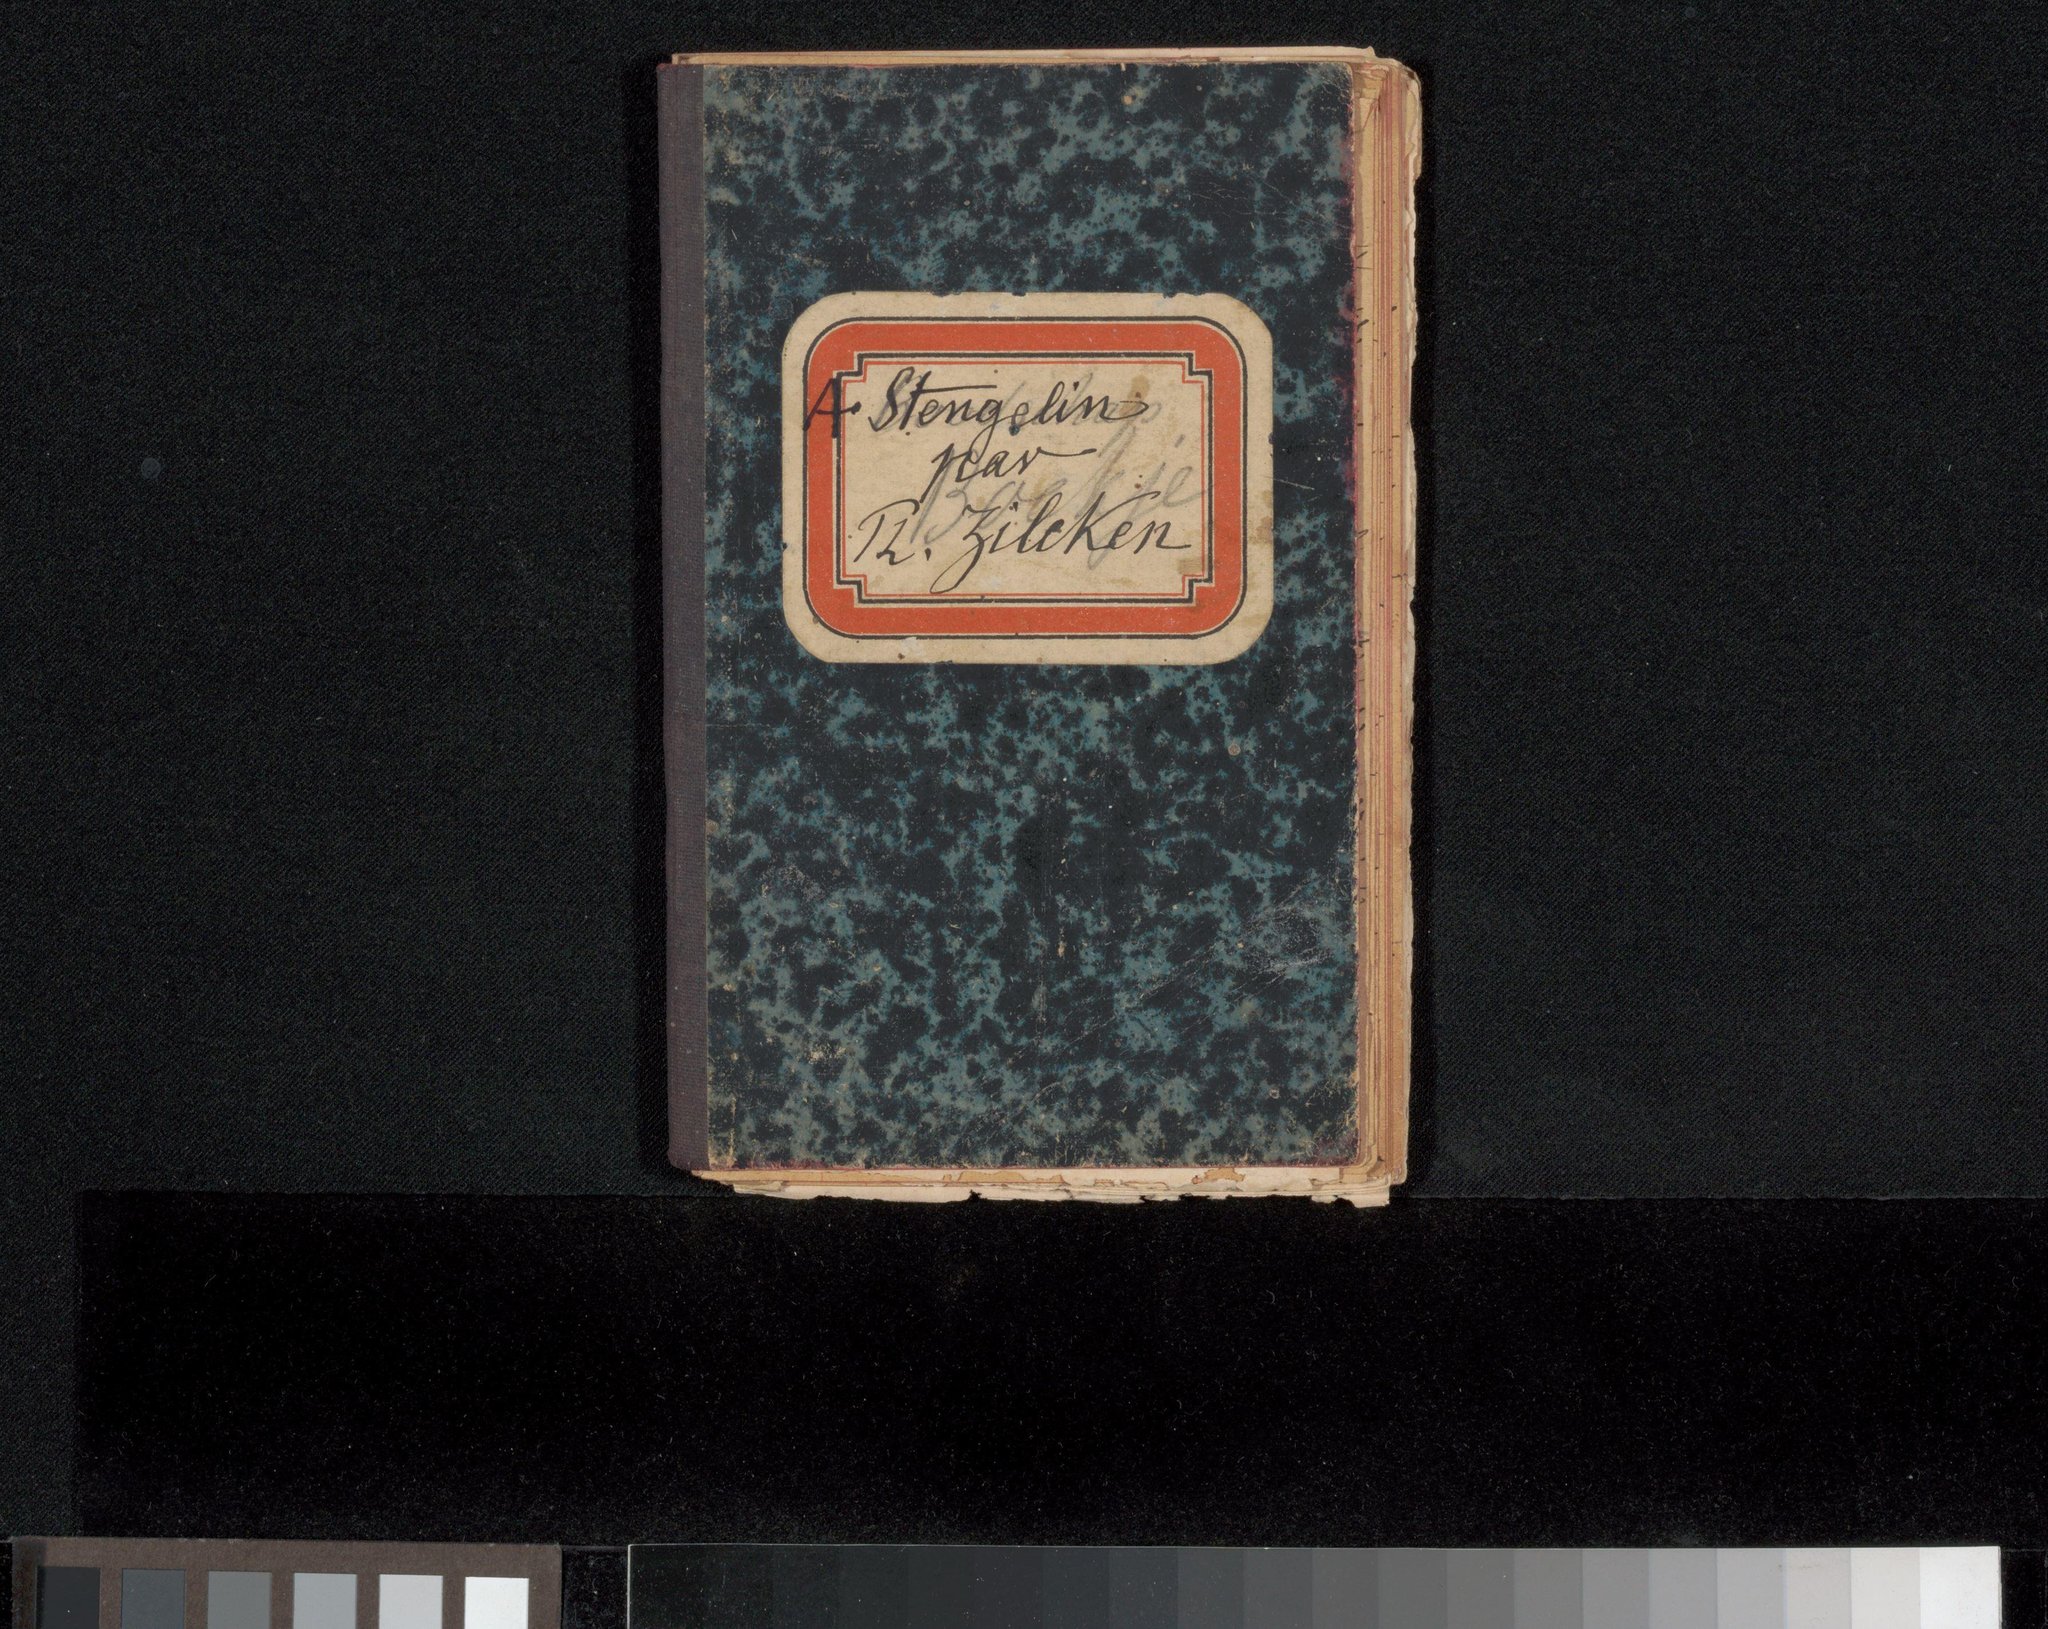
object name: manuscript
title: Manuscript met 50 bladen aan Philip Zilcken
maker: alphonse stengelin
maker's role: painter, print maker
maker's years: 1852-1938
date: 1867-1930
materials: cardboard, ink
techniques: pen, writing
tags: the hague, painter, philip zilcken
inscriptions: collector's mark: ‘RPK’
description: Manuscript bevat correcties door Philip Zilcken.